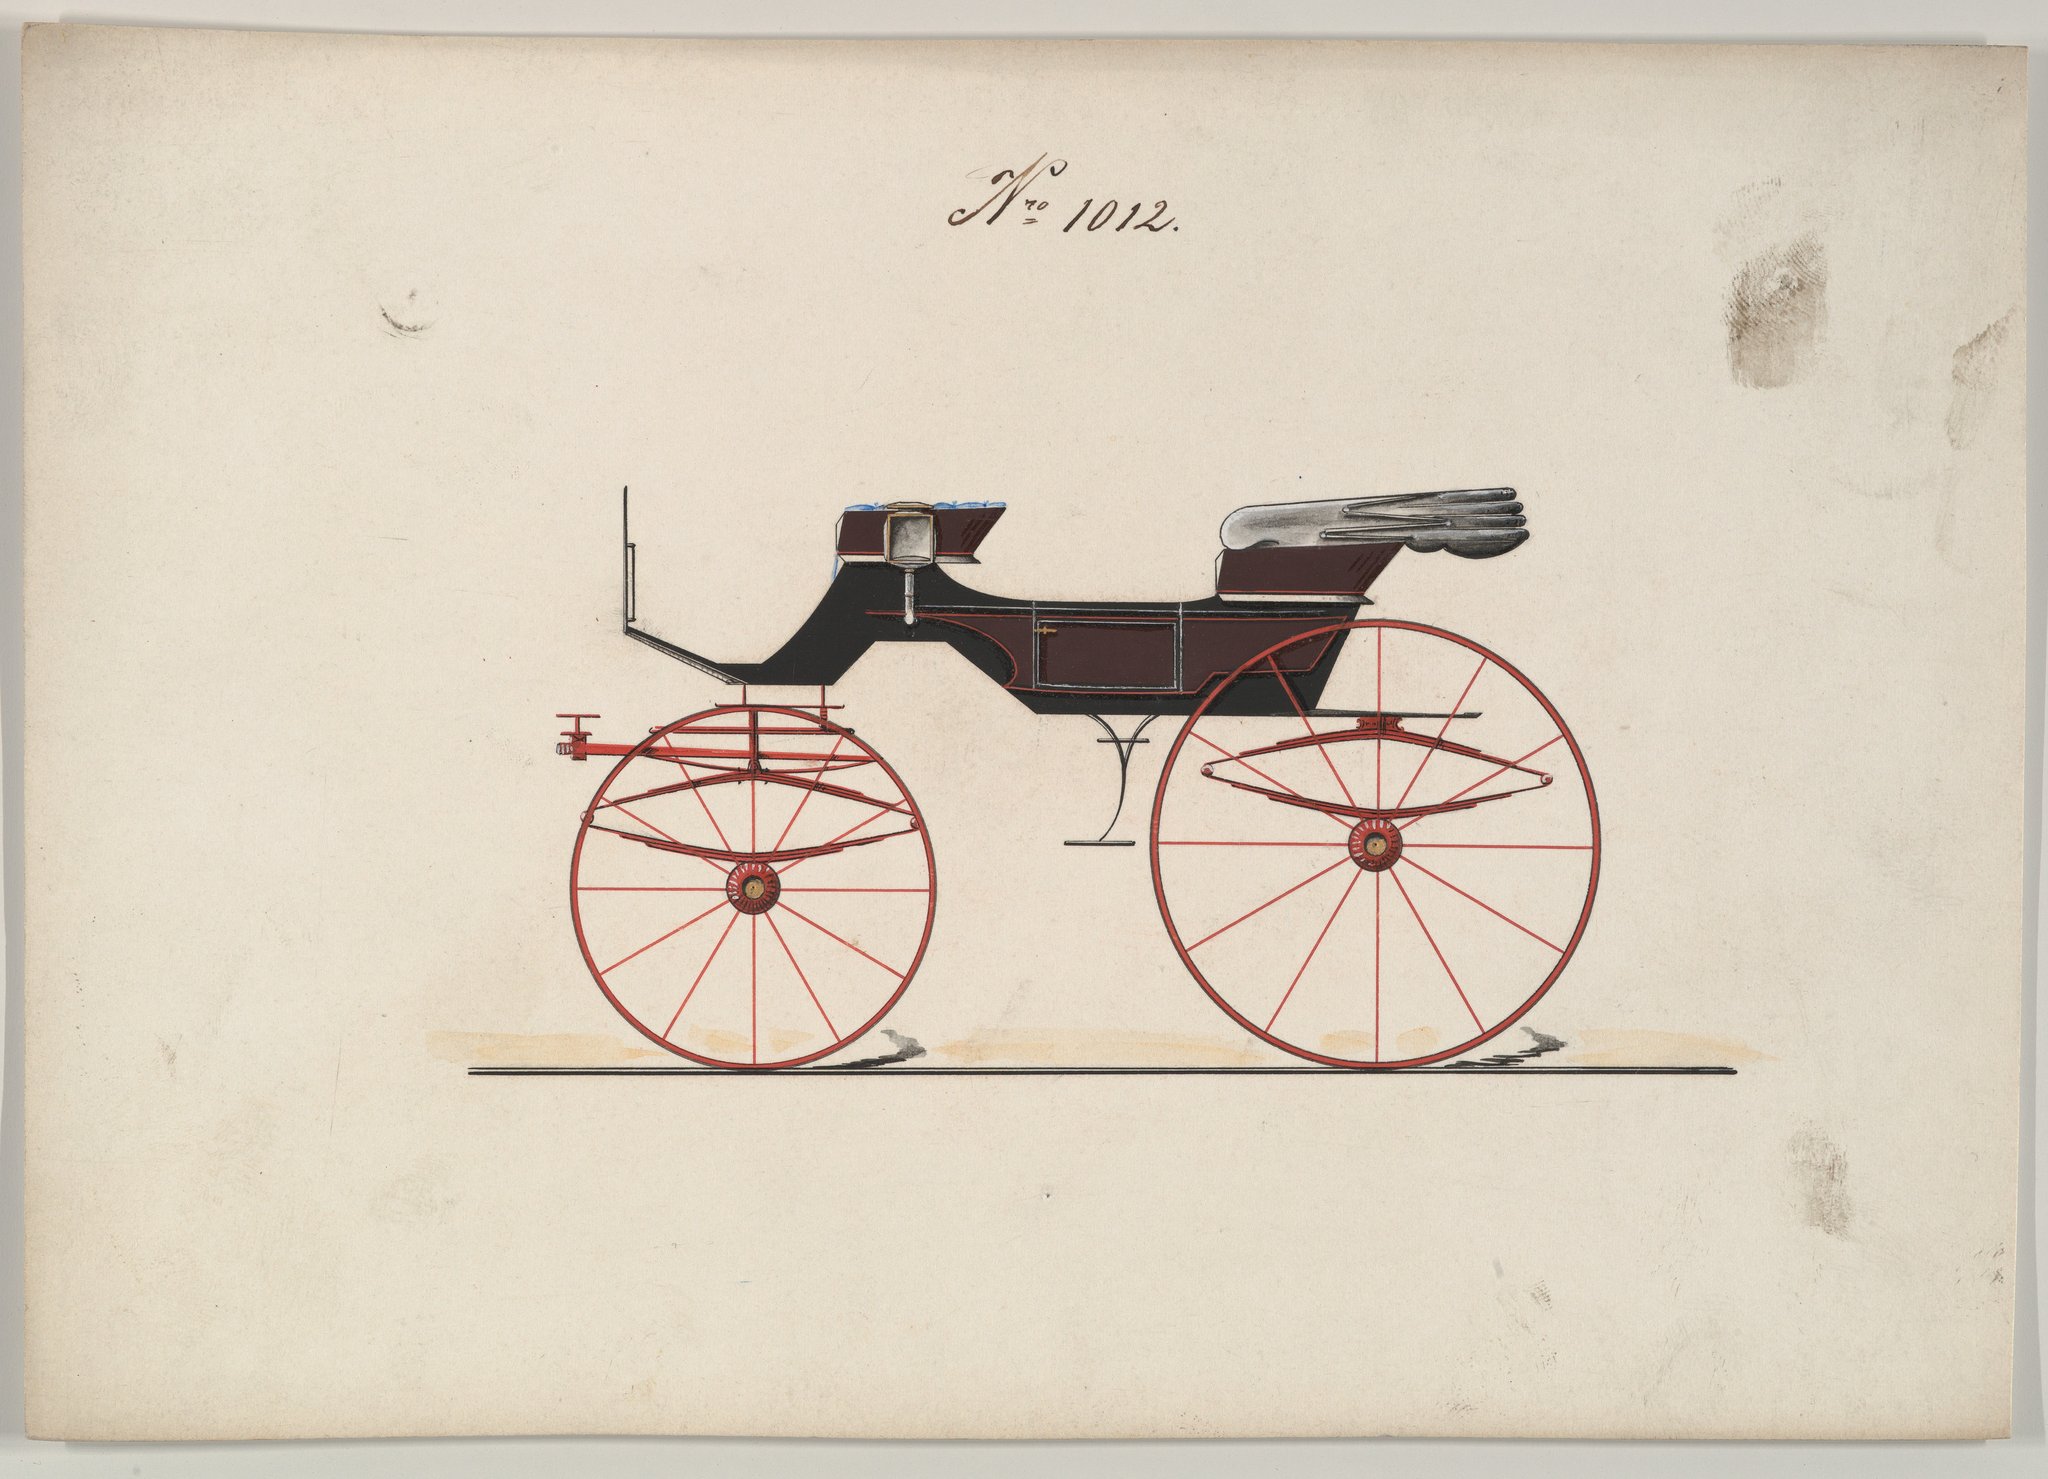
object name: drawing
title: Design for Phaeton, no. 1012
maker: brewster & co.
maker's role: manufacturer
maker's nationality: american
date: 1850-1874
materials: gouache, gum arabic, ink, watercolor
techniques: pen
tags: carriages